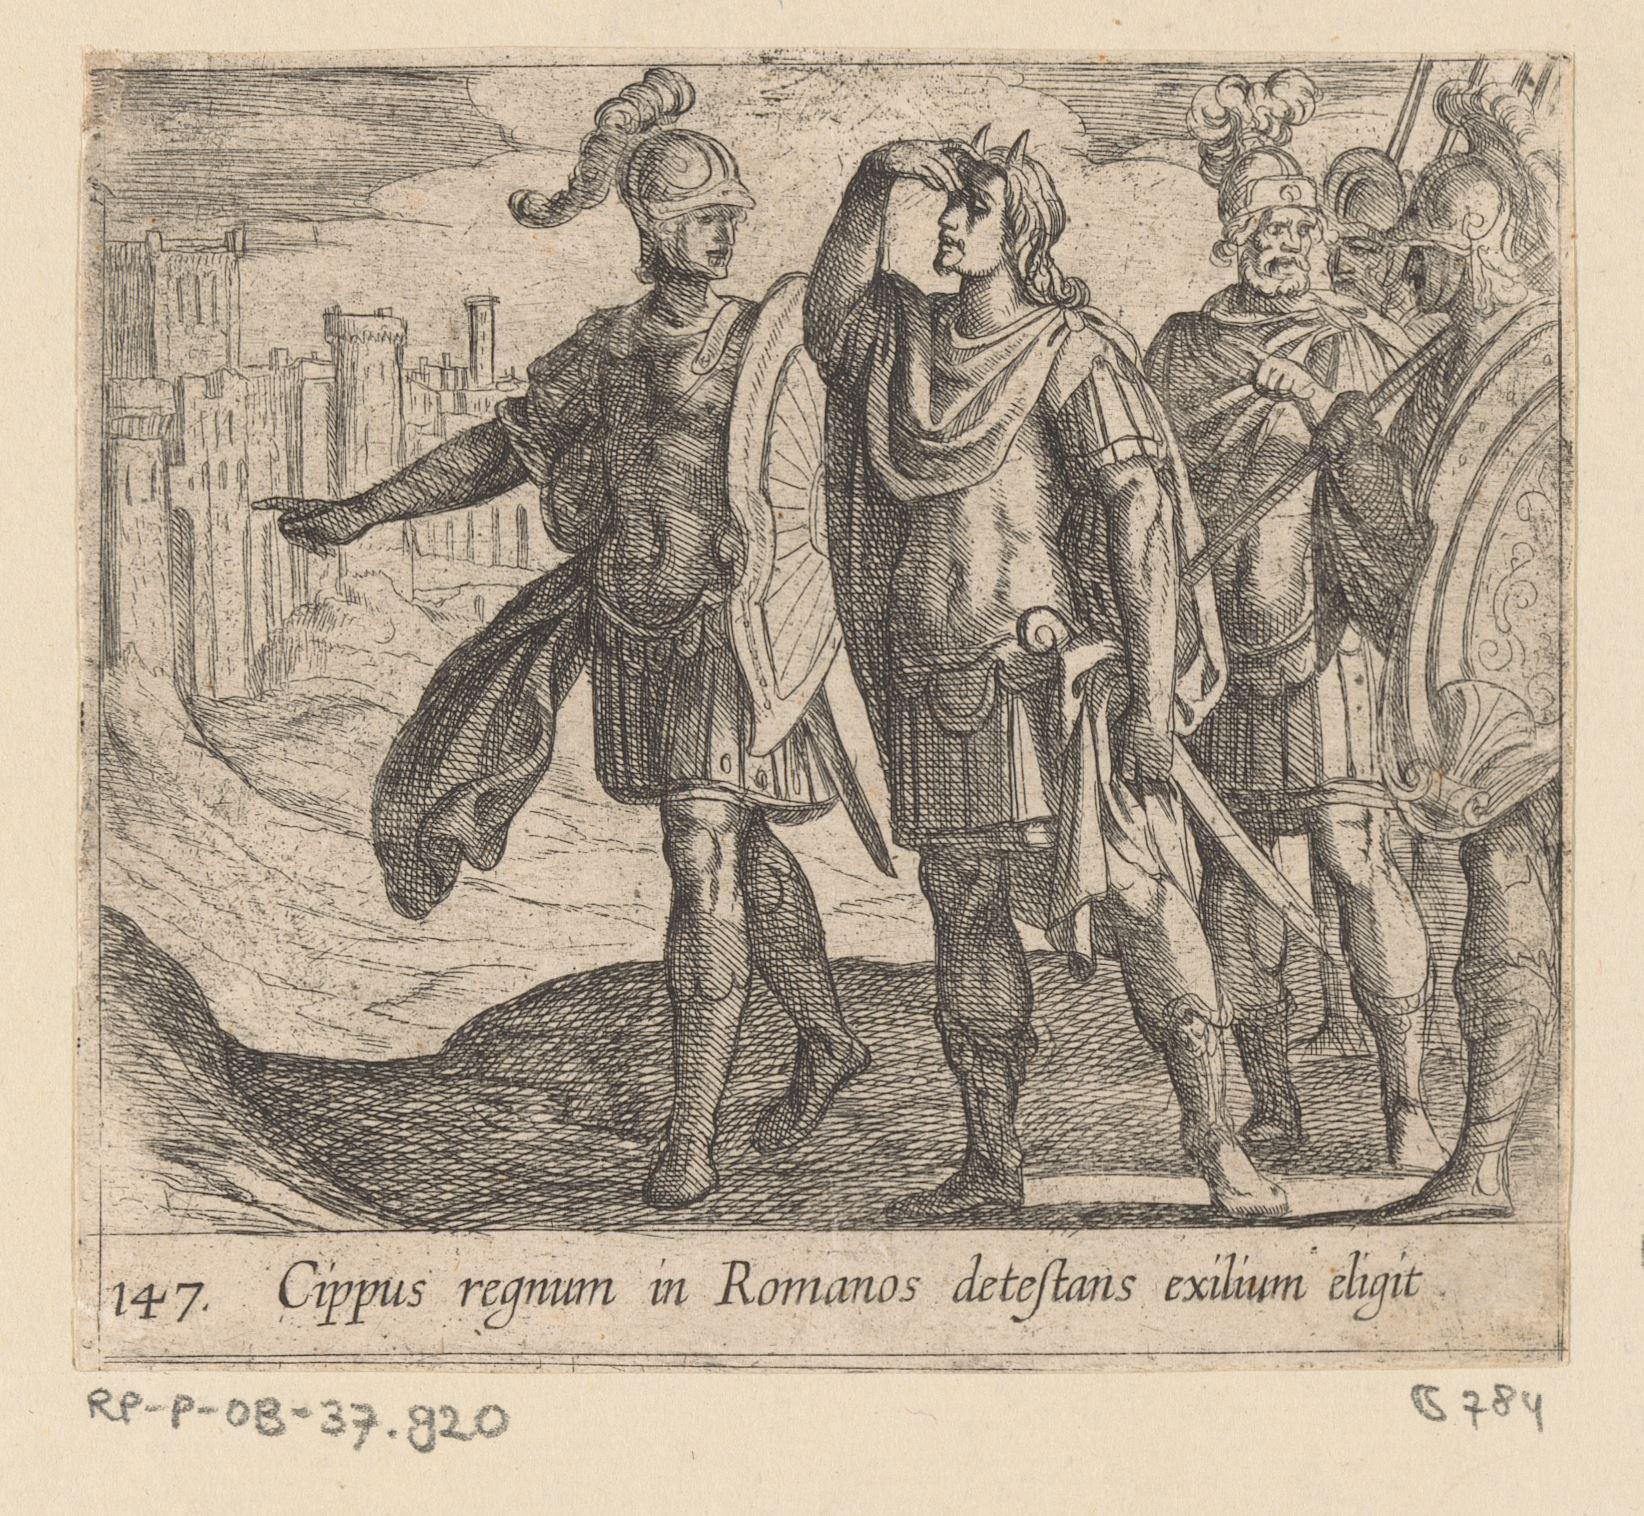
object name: print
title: Metamorphoseon sive transformationum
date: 1606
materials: paper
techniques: etching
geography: italy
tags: horns growing on cipus' head: when horns grow upon his head, cipus, the roman praetor, consults a diviner and is told that he must be king; but rather than destroy the republican constitution he banishes himself (ovid, metamorphoses xv 565)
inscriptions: collector's mark: Lugt 240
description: Deze prent maakt deel uit van een reeks van 150 prenten (+ titelprent) met voorstellingen van de Metamorfosen van Ovidius.